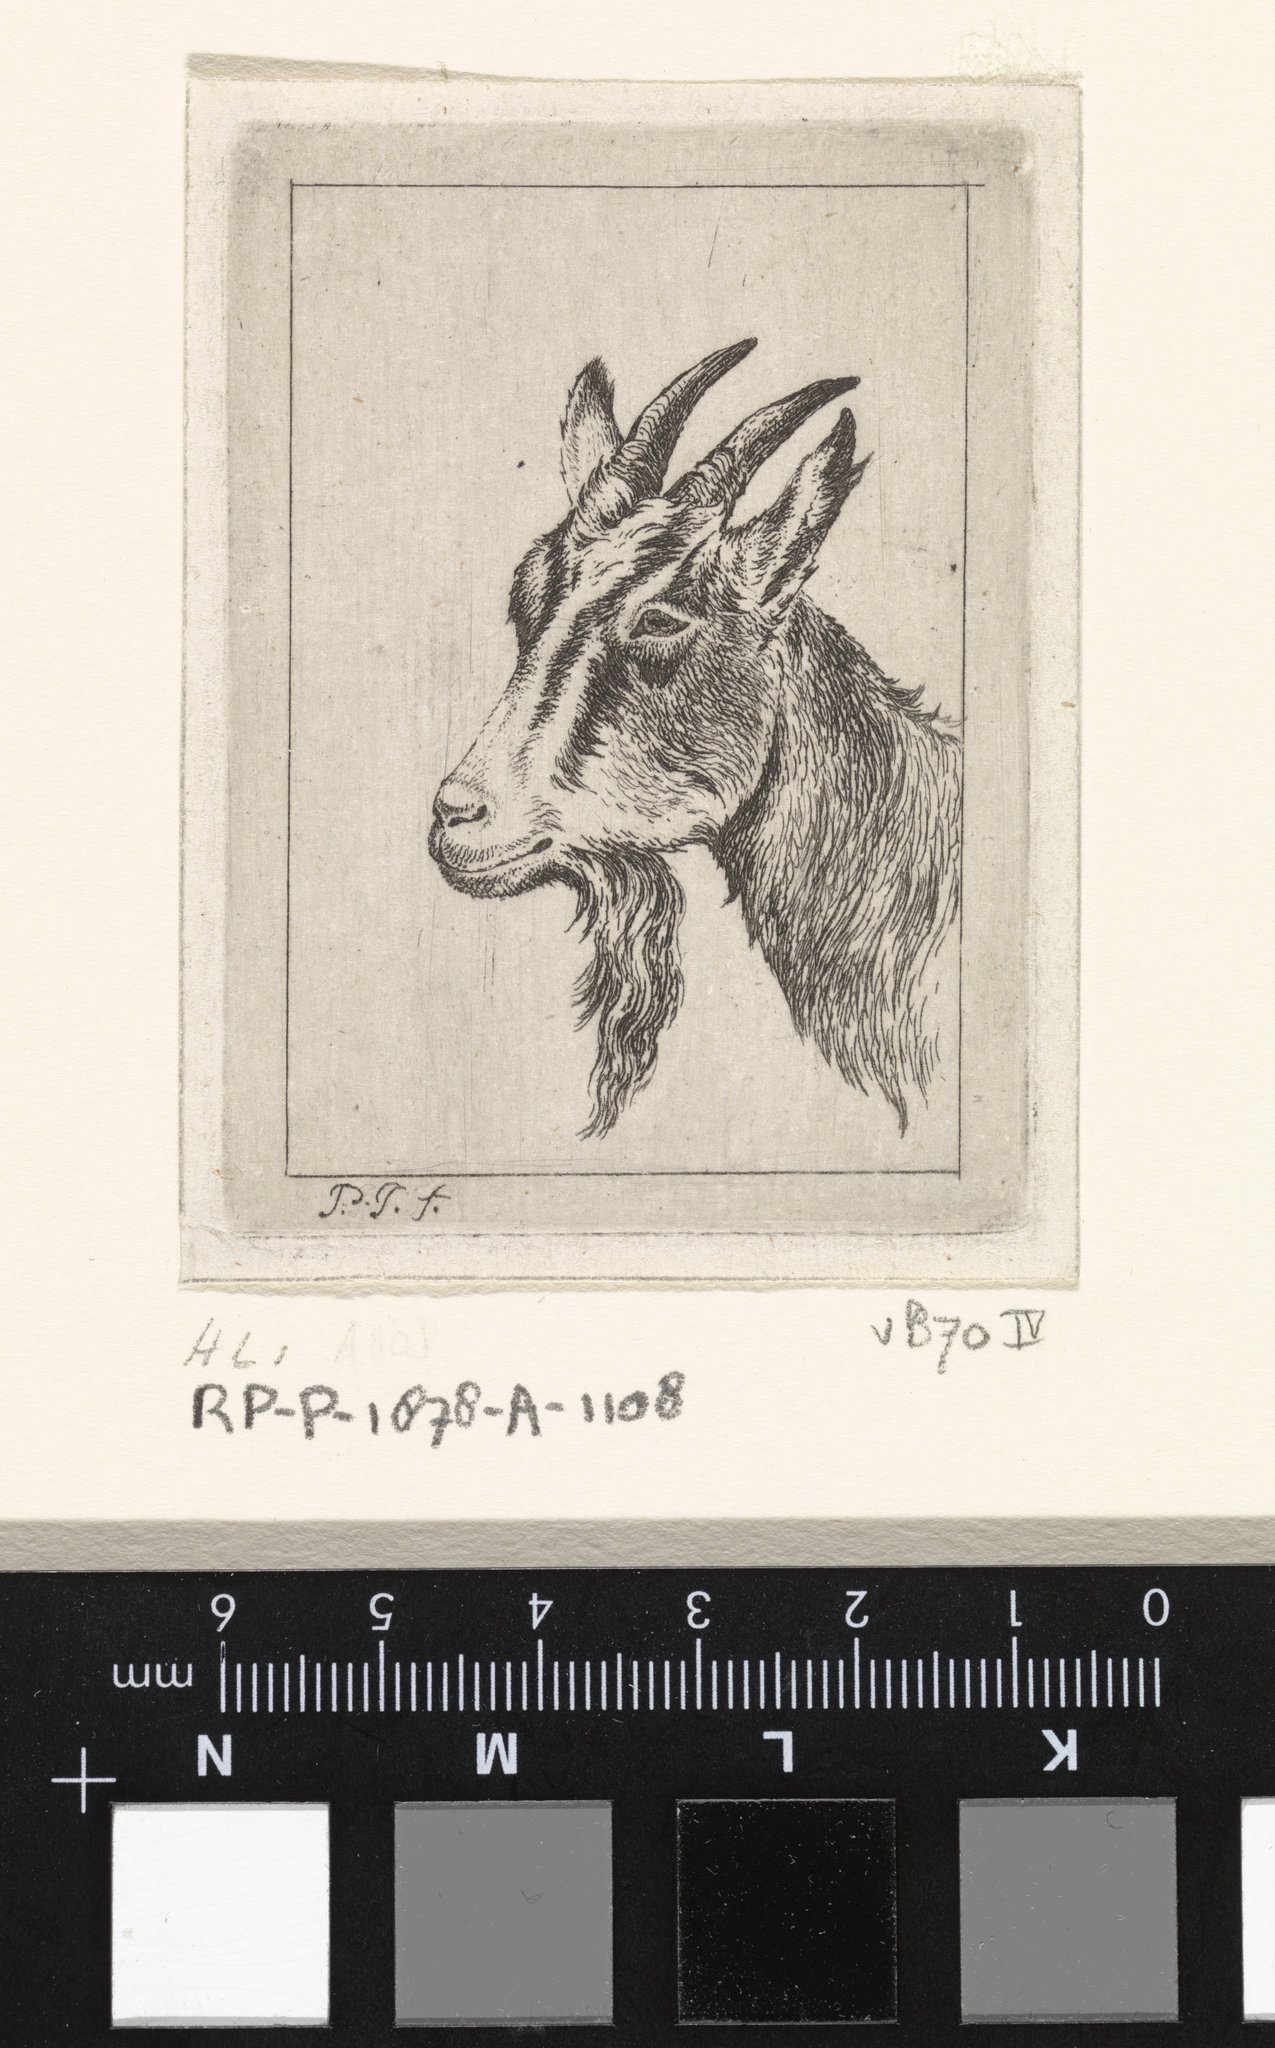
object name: print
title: Bokkenkop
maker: pieter janson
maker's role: draughtsman, print maker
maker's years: 1765-1851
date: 1780-1851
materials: paper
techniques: etching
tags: he-goat, billy-goat (+ male animal)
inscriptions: collector's mark: Lugt 2227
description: Kop van een bok naar links. Afdruk van de bovenste helft van de oorspronkelijke - nu in tweeën gesneden - plaat.